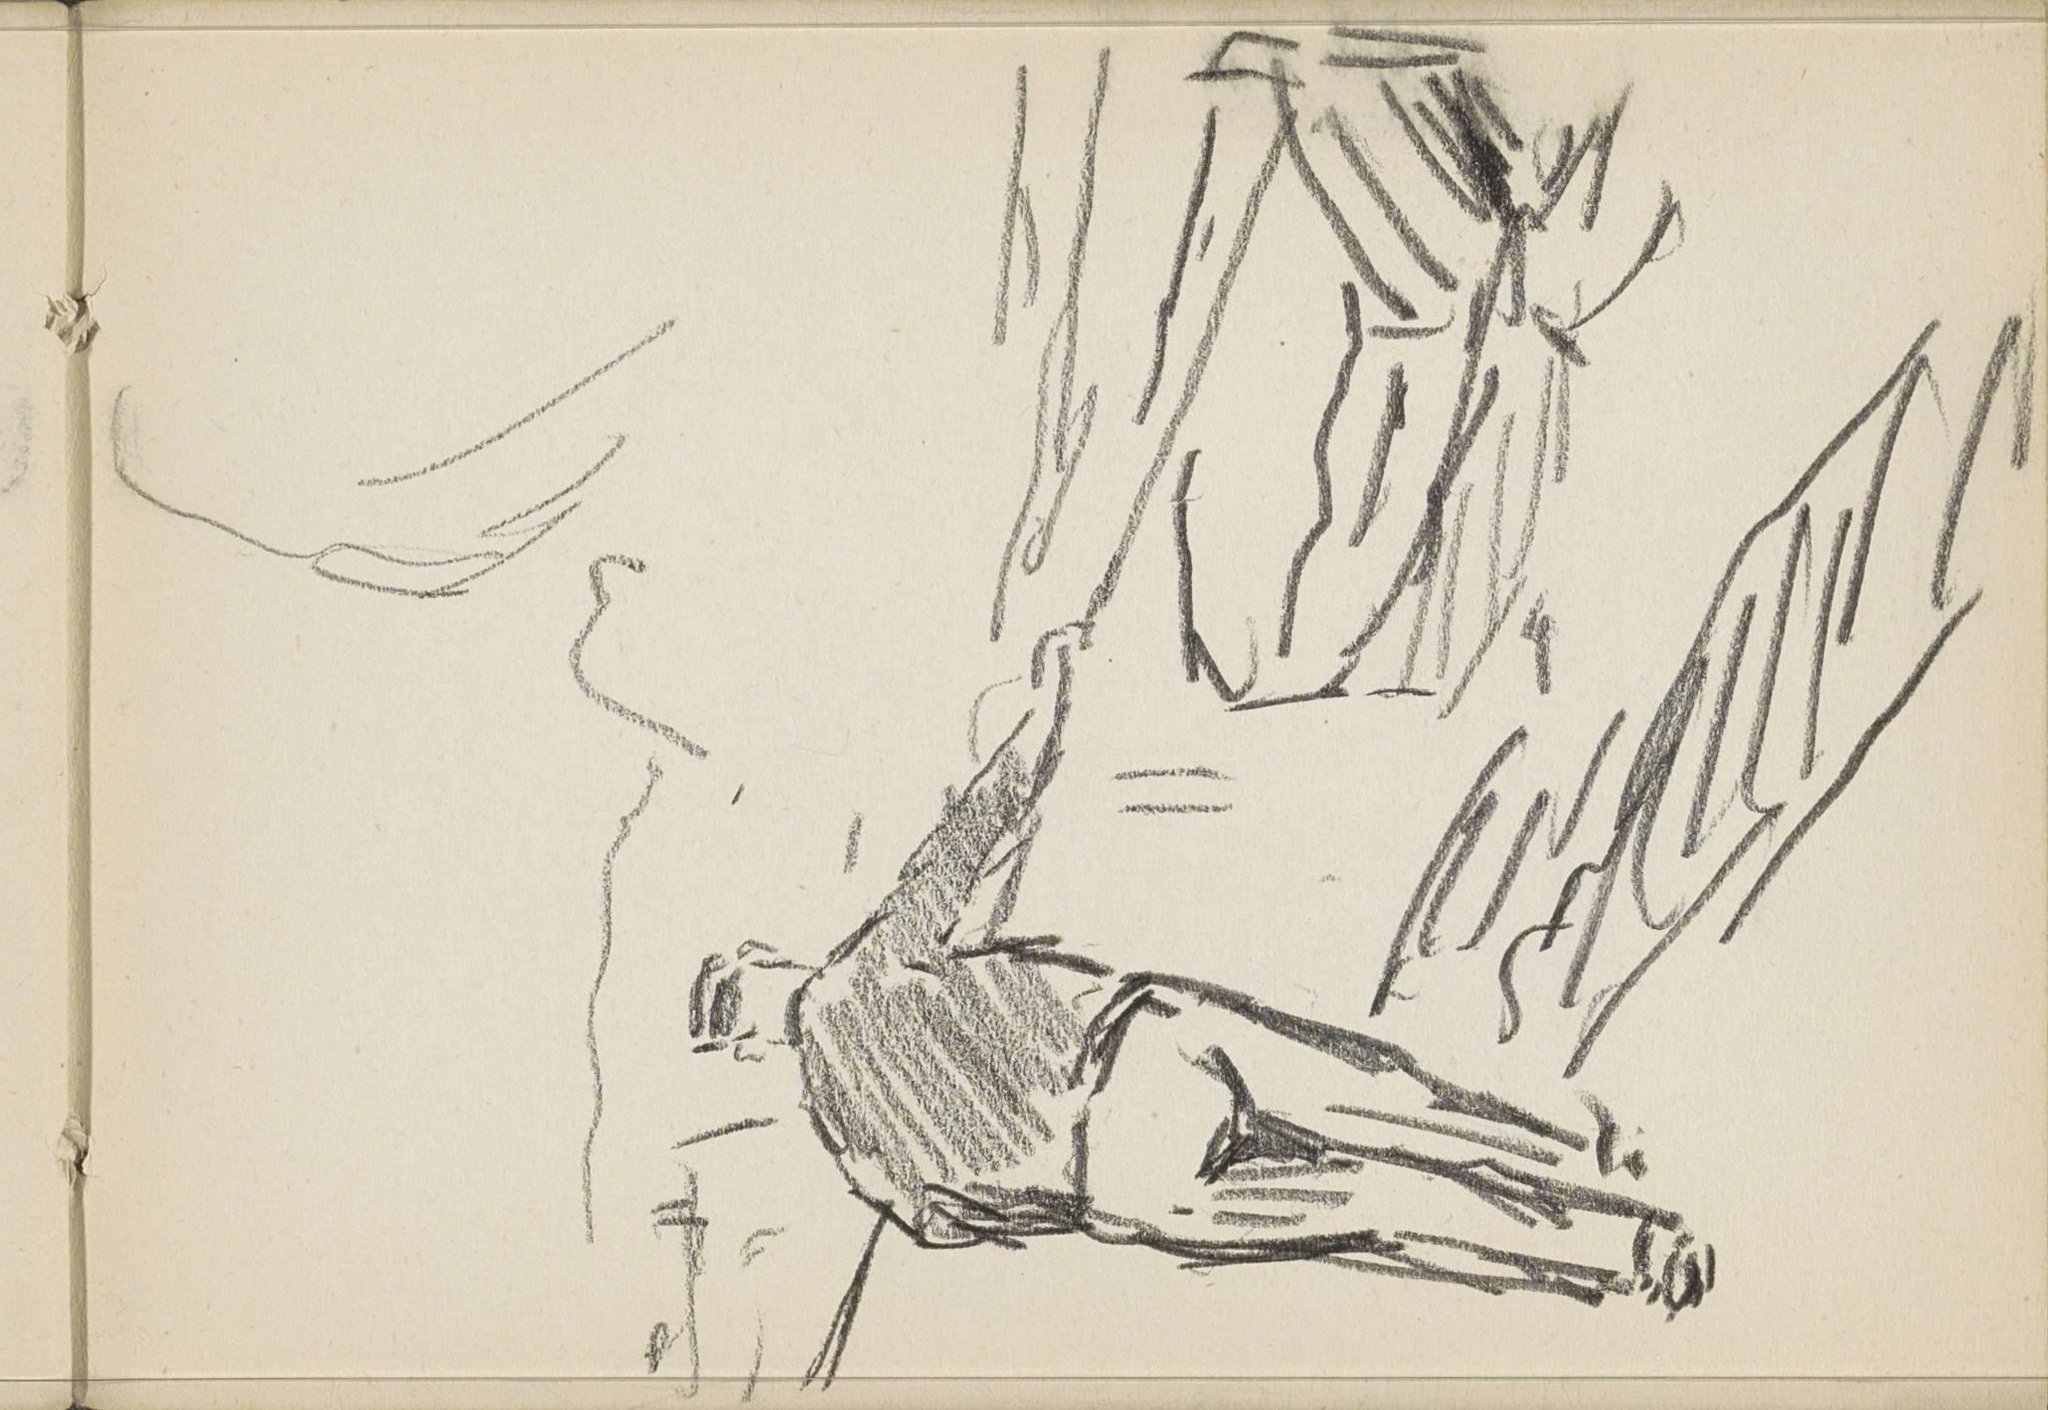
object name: sketchbook leaf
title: Man op jaagpad die een boot voortduwt met een stok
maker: alexander shilling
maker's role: draughtsman, print maker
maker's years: 1859-1937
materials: chalk, paper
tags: towing path (+ landscape with figures, staffage), boat propelled by man or animal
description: De man leunt met zijn gewicht op de boom en duwt zo de boot op het water voort. Blad 15 recto uit een schetsboek met 30 bladen.